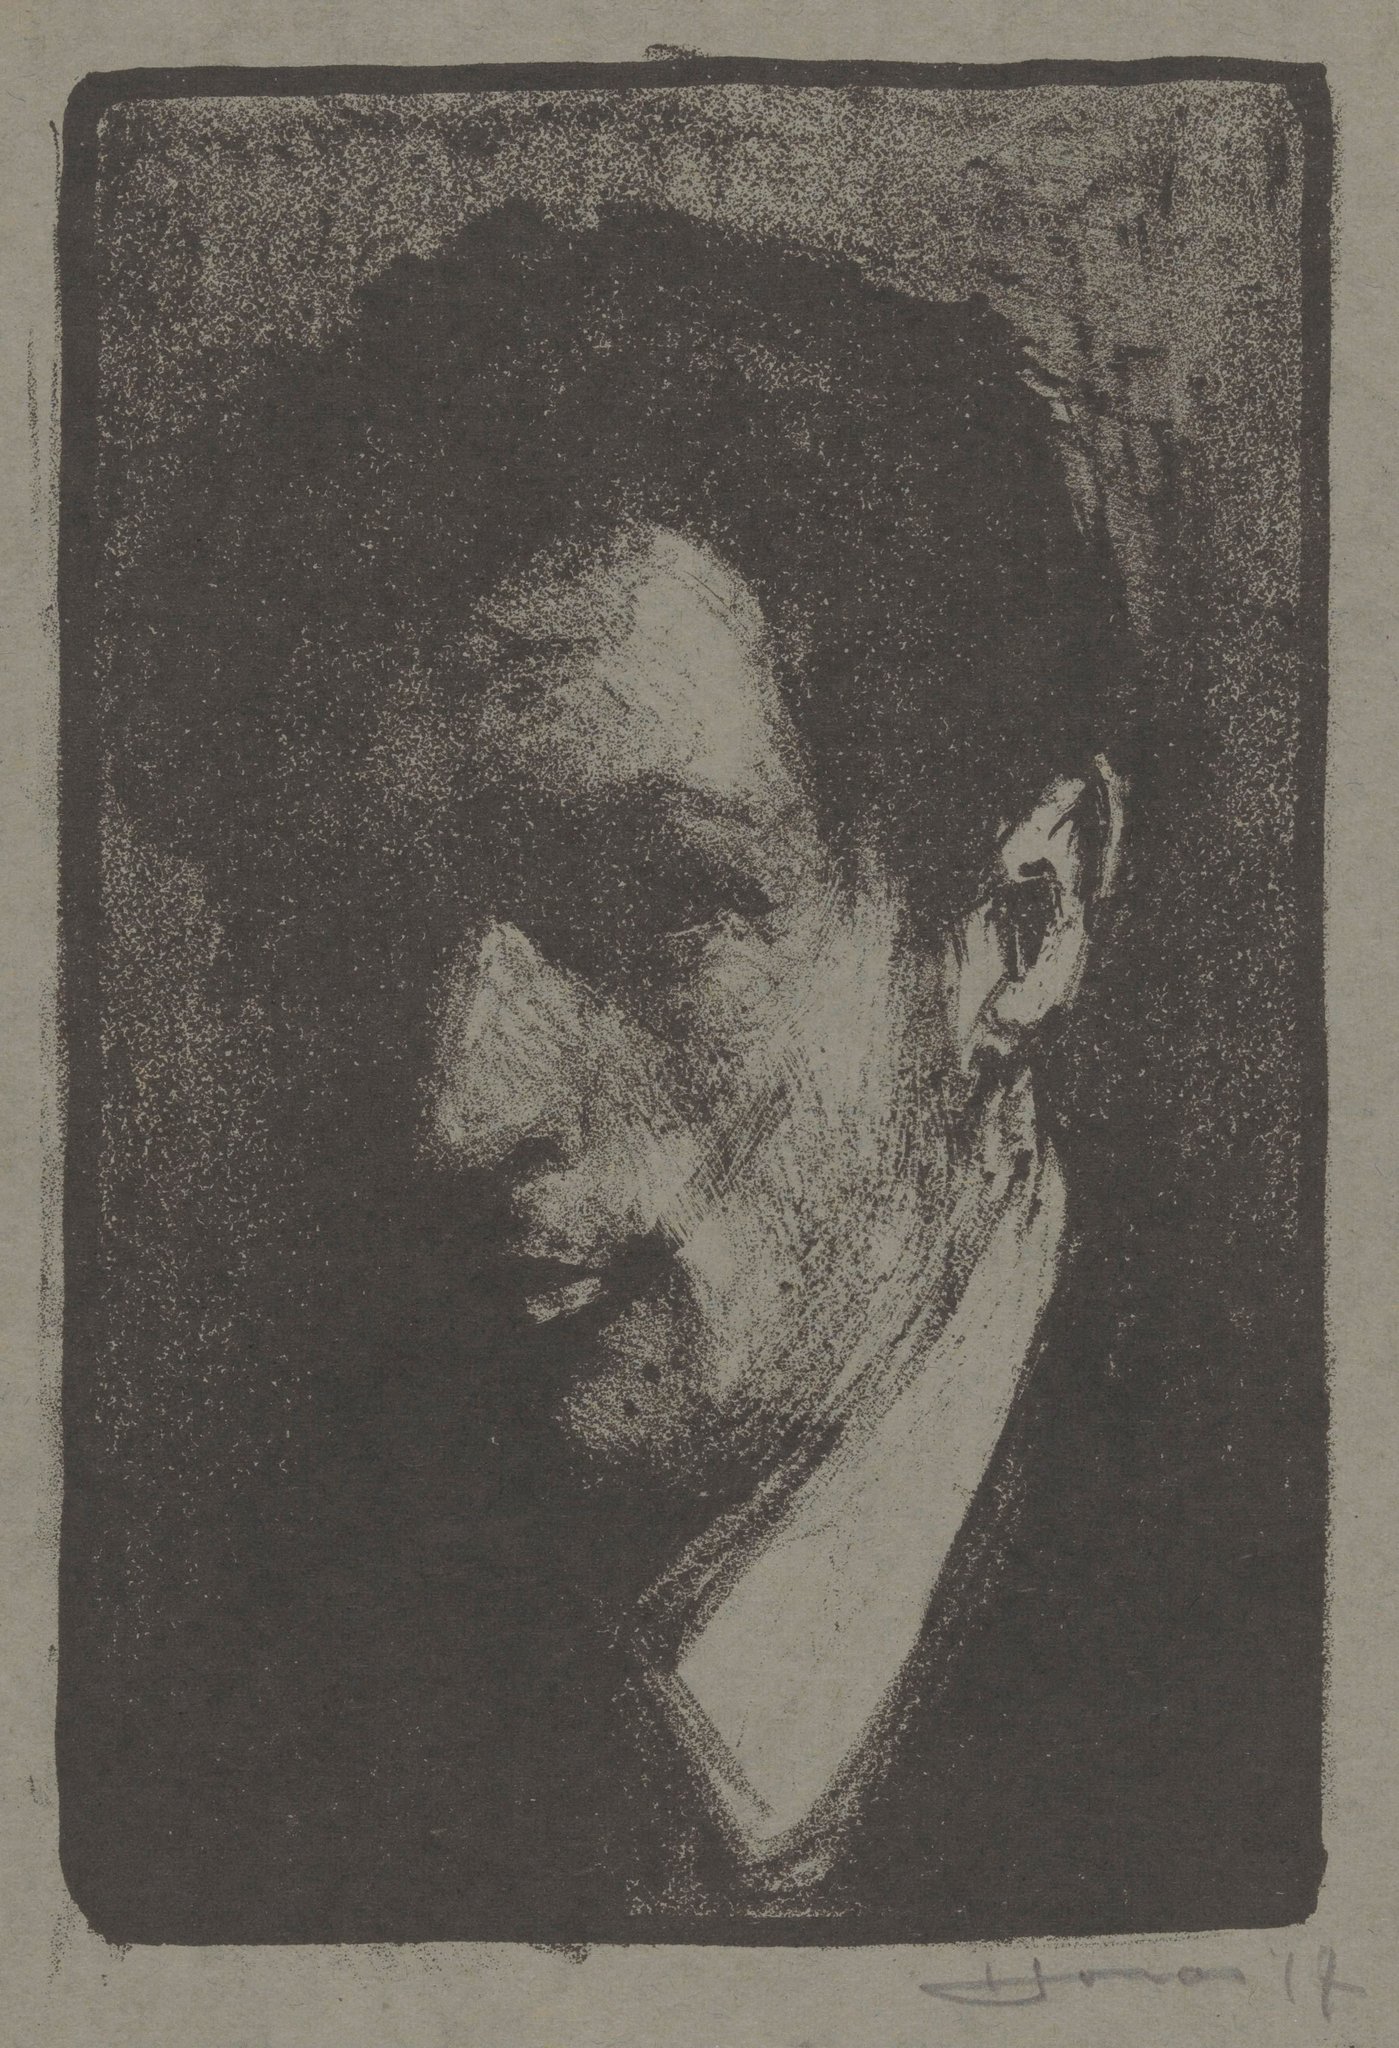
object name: print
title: Zelfportret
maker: henri jonas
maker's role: draughtsman, print maker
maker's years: 1878-1944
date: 1917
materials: paper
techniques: lithograph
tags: maastricht, print maker, draughtsman, henri jonas, portrait, self-portrait of artist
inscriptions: collector's mark: Lugt 2228